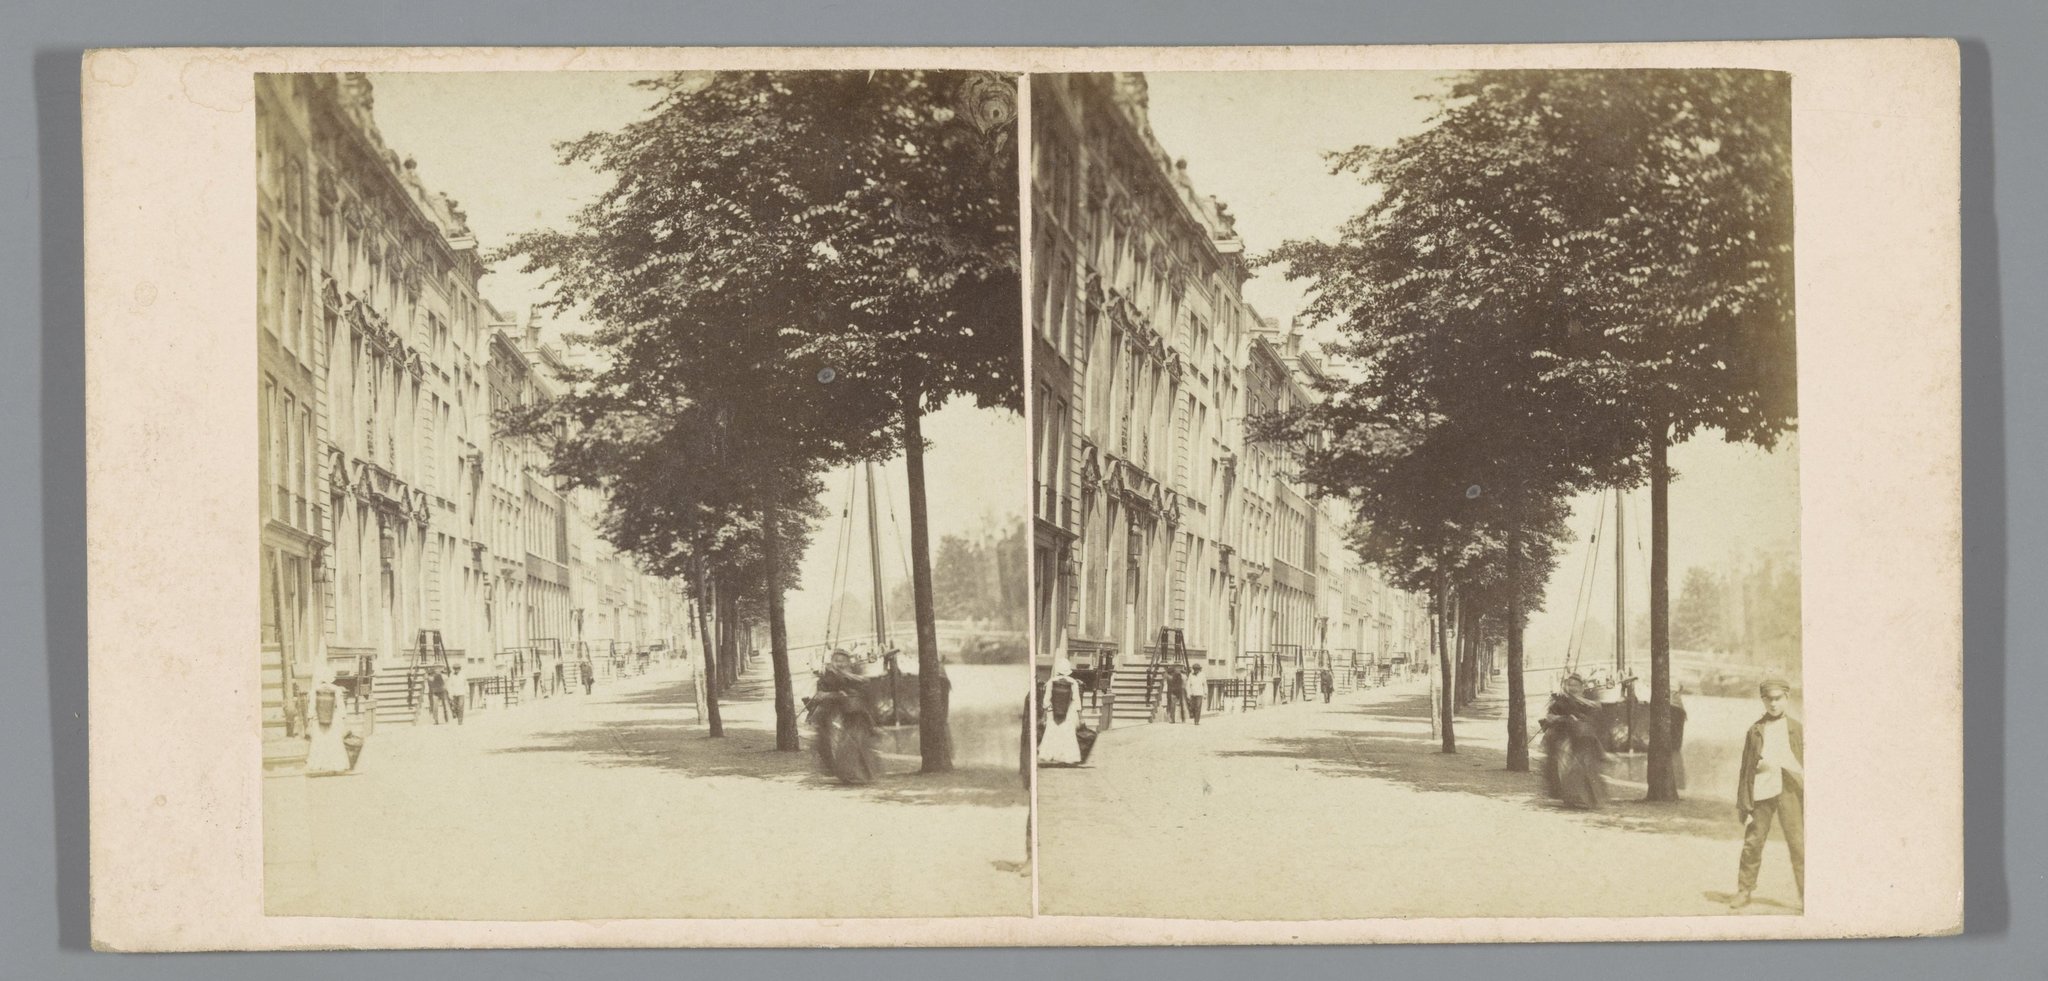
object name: stereograph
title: Gezicht op de Keizersgracht bij het Molenpad in Amsterdam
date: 1860-1885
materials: cardboard, photographic support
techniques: albumen print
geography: amsterdam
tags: street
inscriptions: inscription: ‘DE KEIZERSGRACHT/ BIJ HET/ Molenpad te Amsterdam./ A. JAGER, WATER 110, TE AMSTERDAM.’